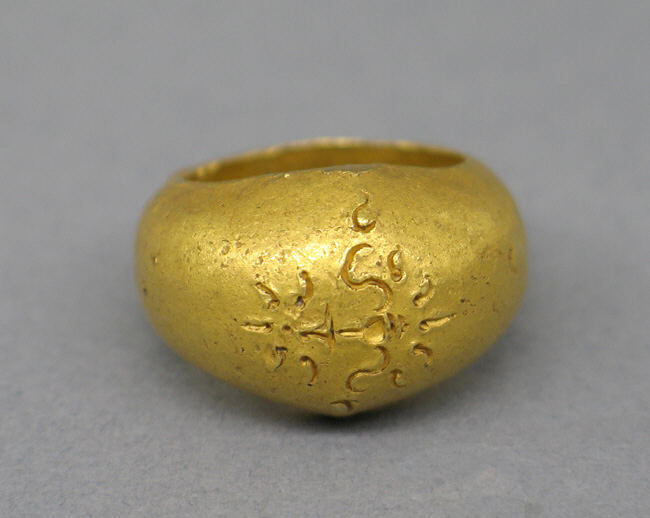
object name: ring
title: Solid Cast Ring with Sri Inscription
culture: indonesian, javanese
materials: gold